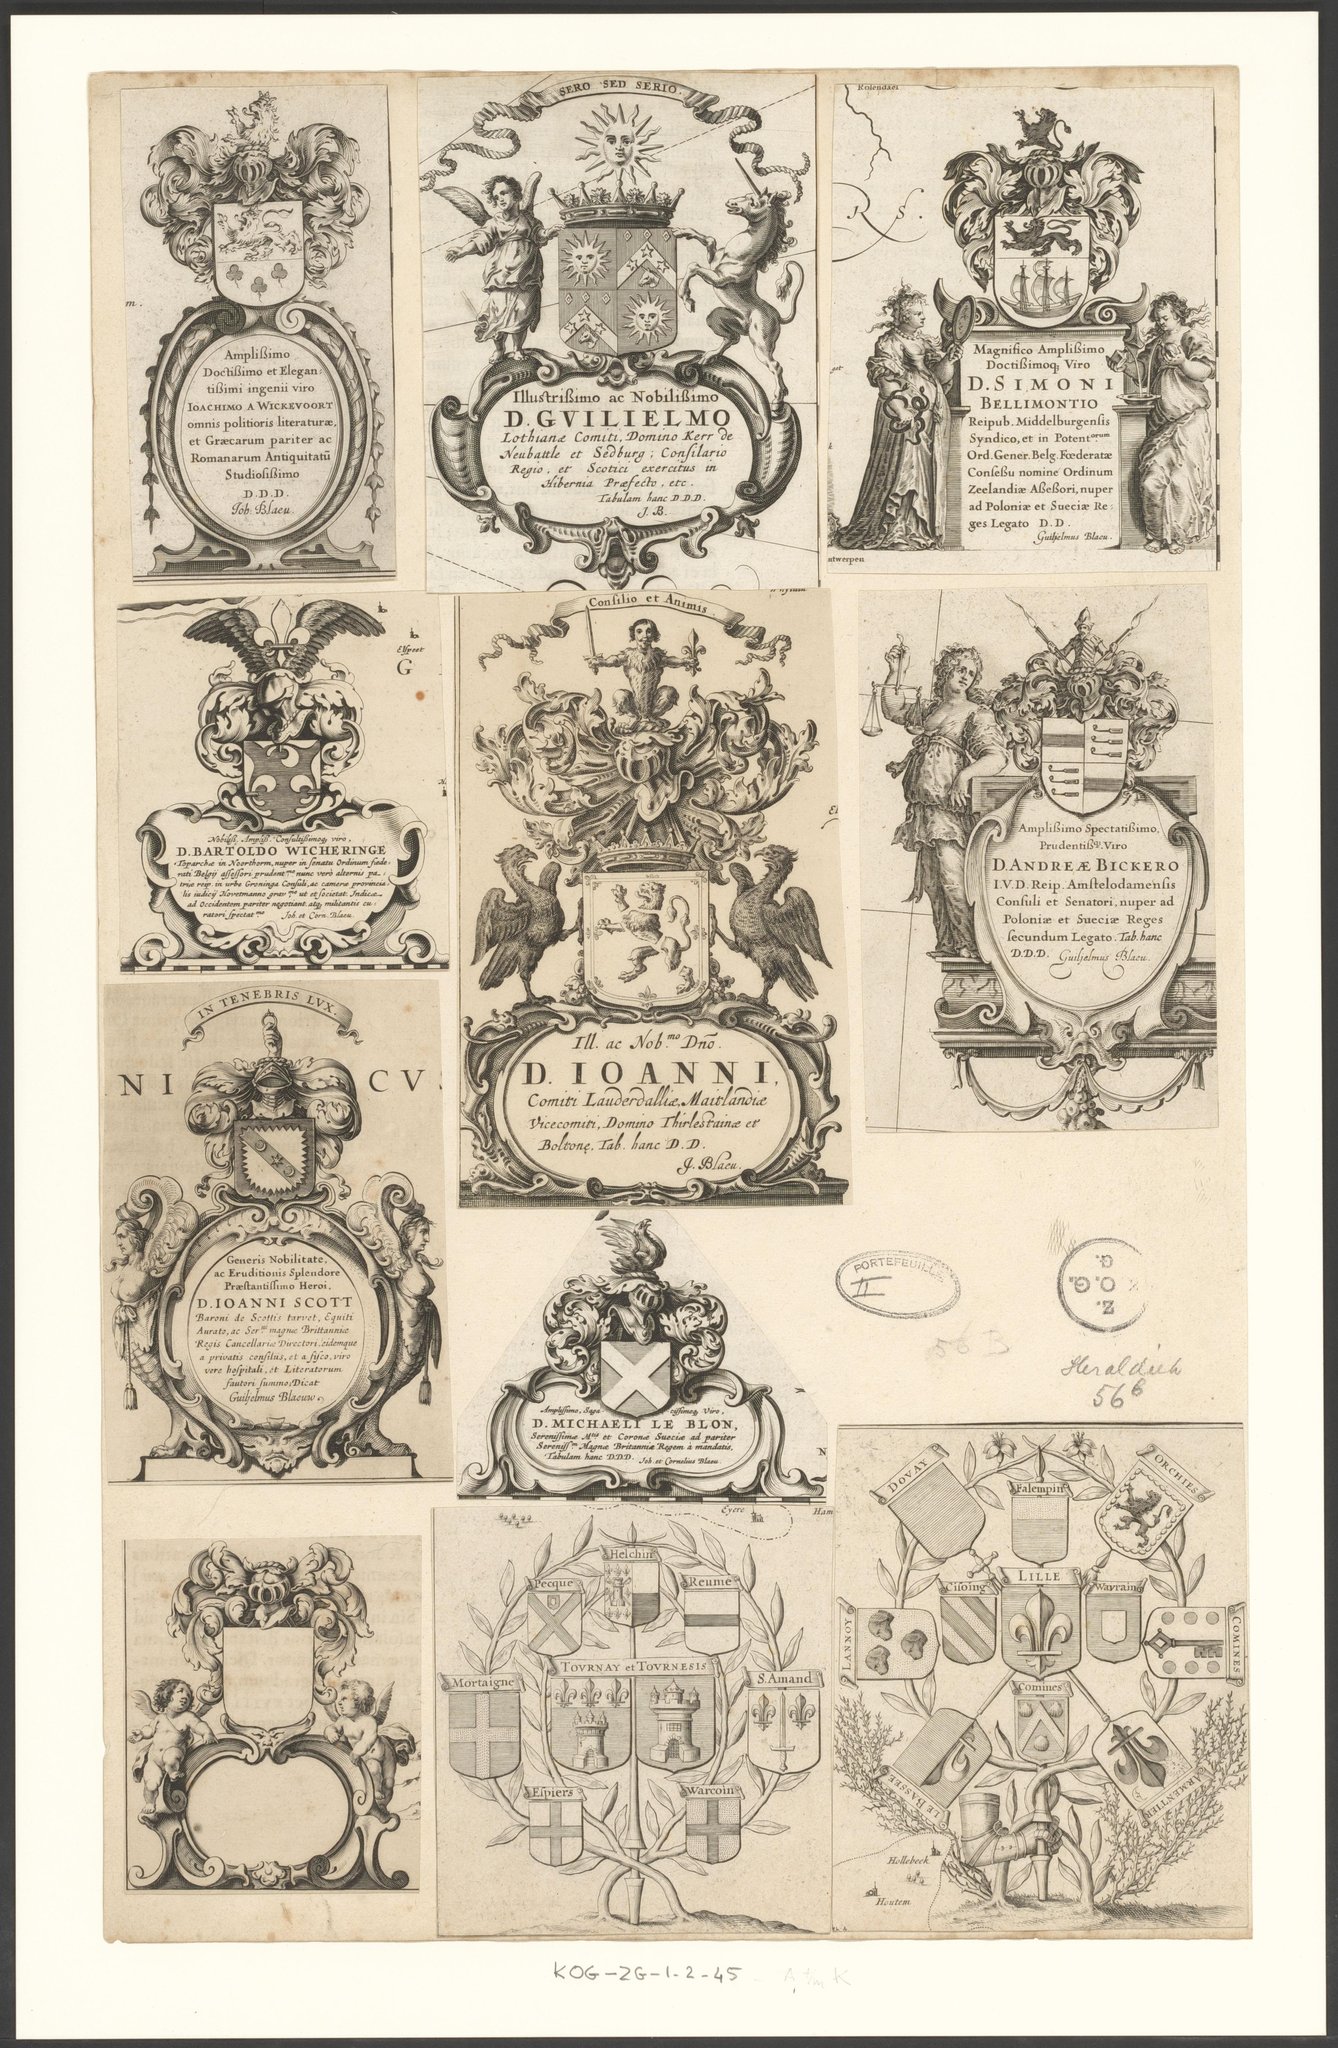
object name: print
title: Blad met 11 diverse wapens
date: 1600-1699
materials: paper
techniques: engraving, etching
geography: netherlands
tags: armorial bearing, heraldry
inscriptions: collector's mark: Lugt 1641, collector's mark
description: Blad met 11 diverse familiewapens, merendeels met de opdrachten door de uitgevers uit de familie Blaeu. Stukken papier in verschillende formaten, sommige met gedrukte tekst op verso, uitgeknipt en opgeplakt, Onderwerpsrubrieken binnen de Atlas Zeden en Gewoonten: Regeering, Wapens (Heraldiek), Geslachtswapens.